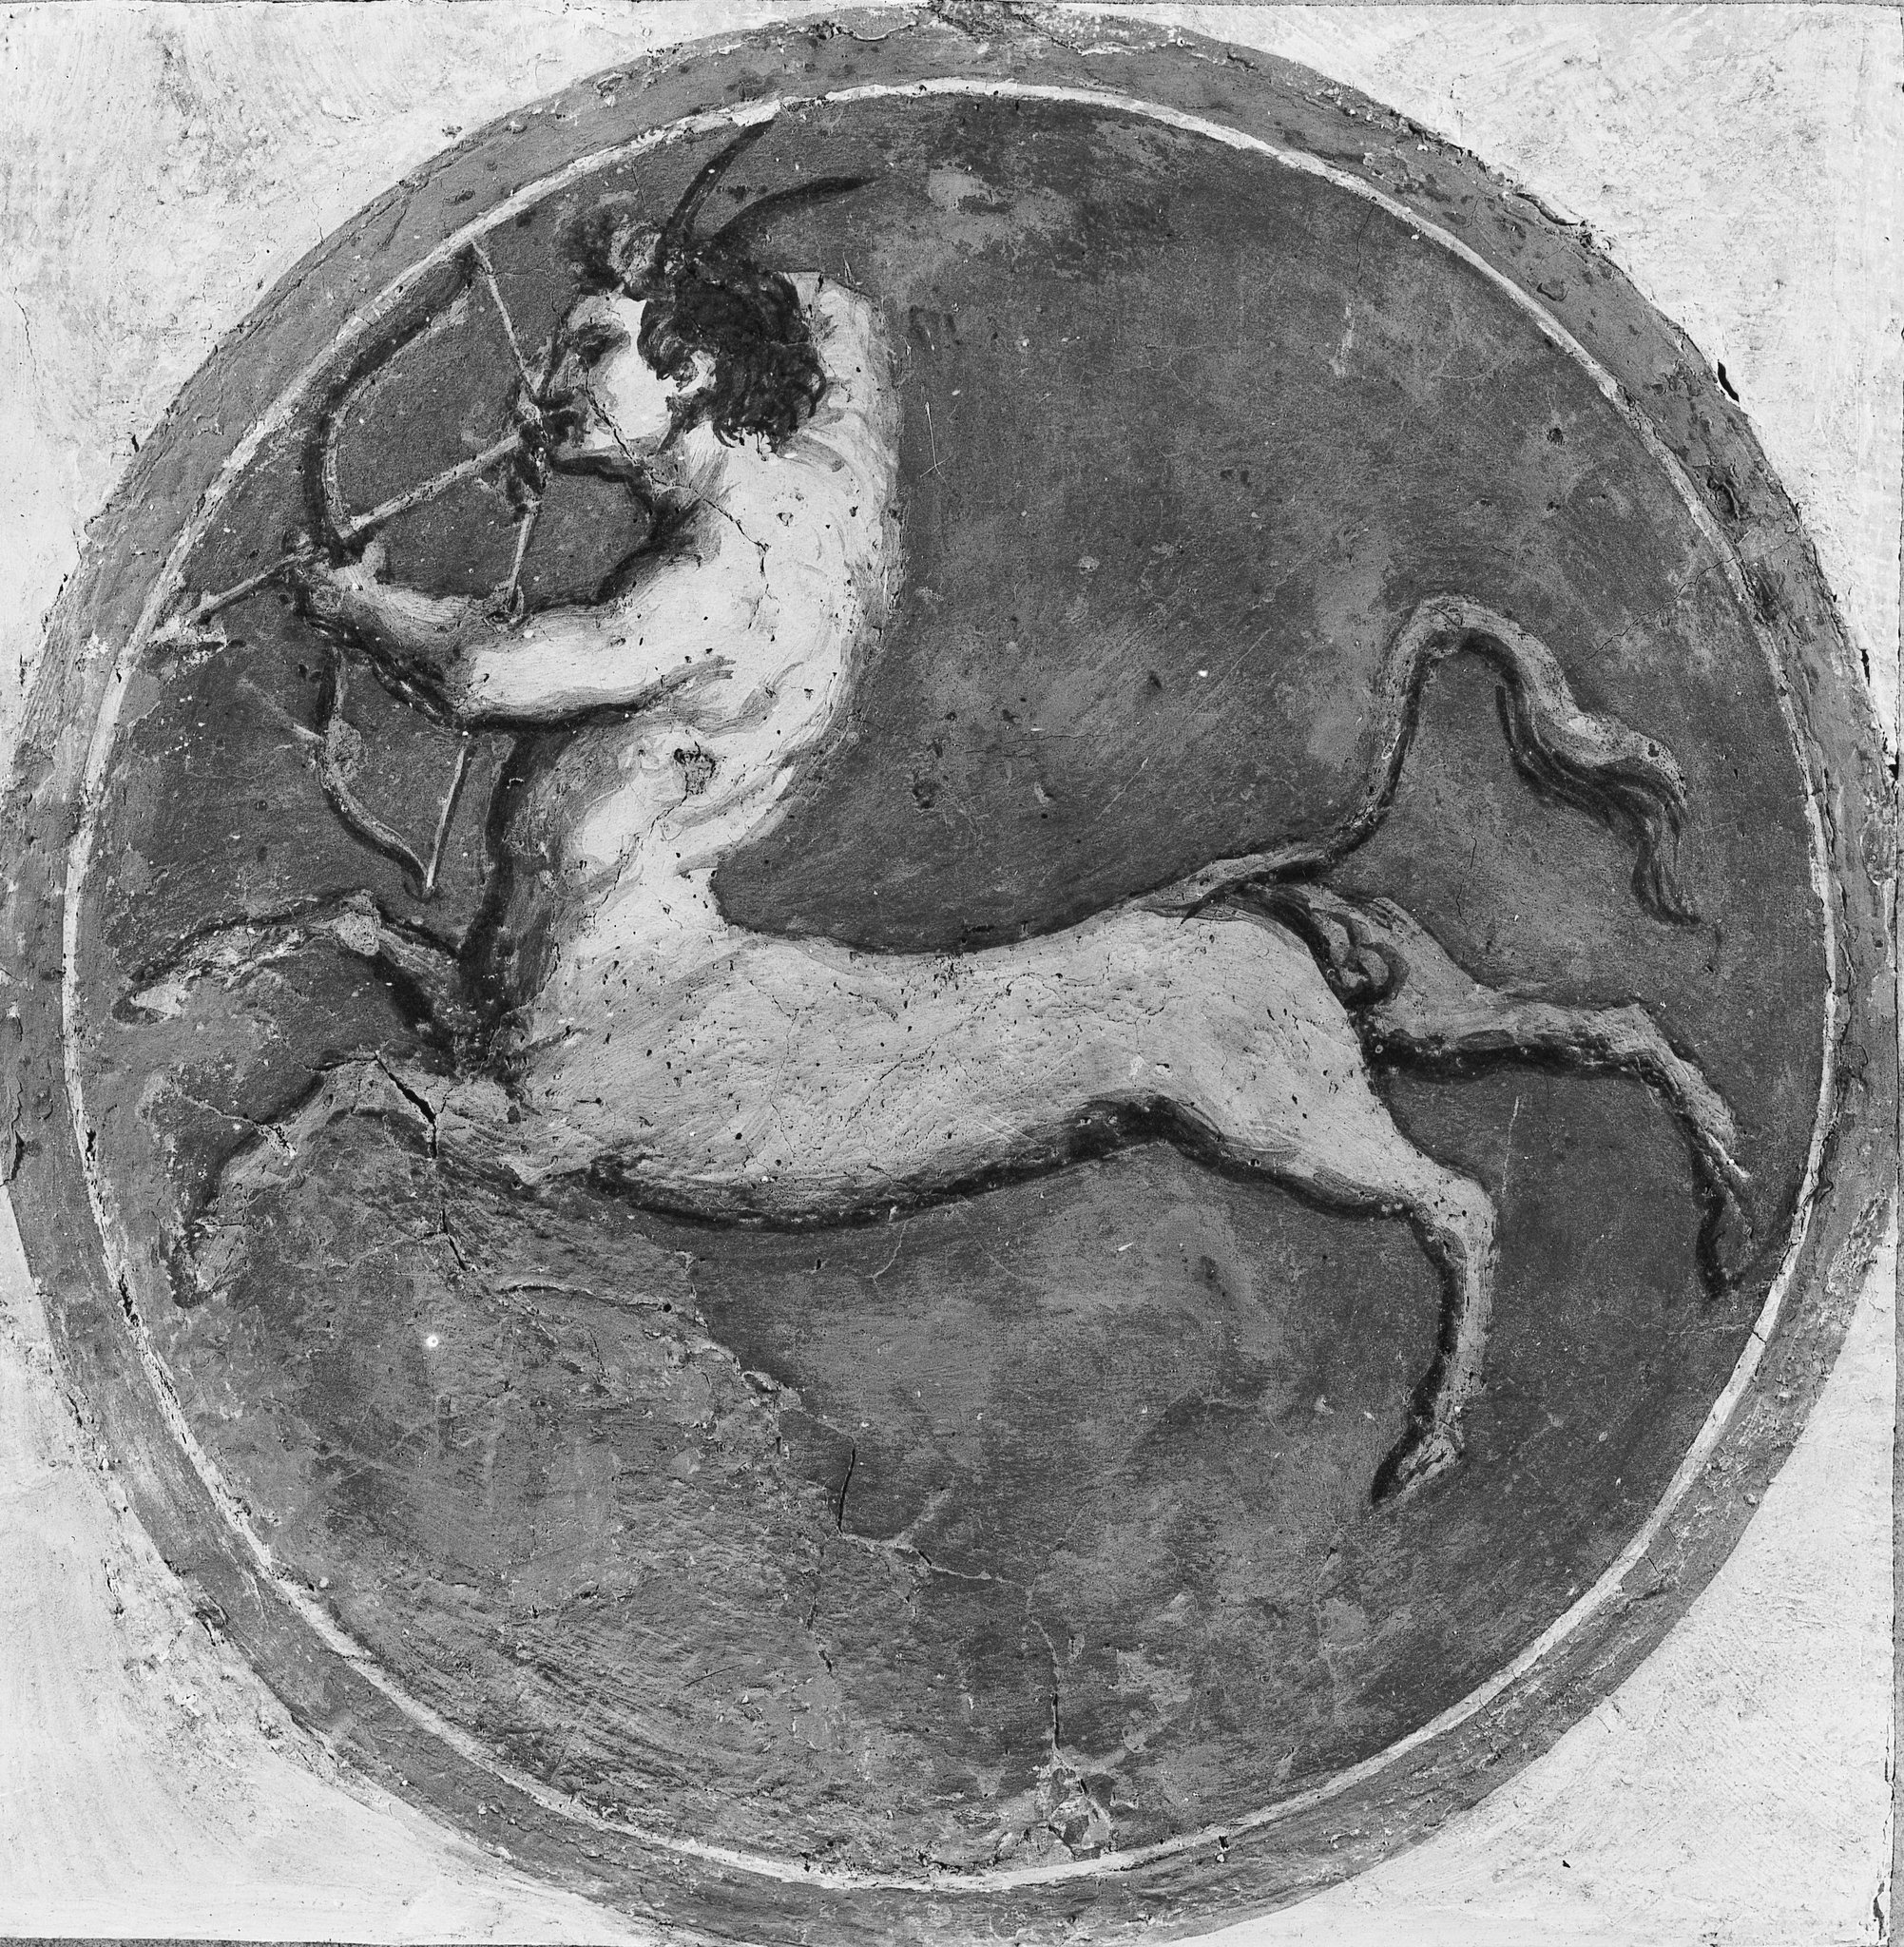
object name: painting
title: Frescoes from the Villa Stati-Mattei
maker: baldassarre tommaso peruzzi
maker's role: artist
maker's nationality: italian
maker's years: 1481-1536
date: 1501-1536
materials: canvas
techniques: fresco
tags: bow and arrow,cupid,apollo,hercules,centaurs,jupiter,minerva,venus,zodiac